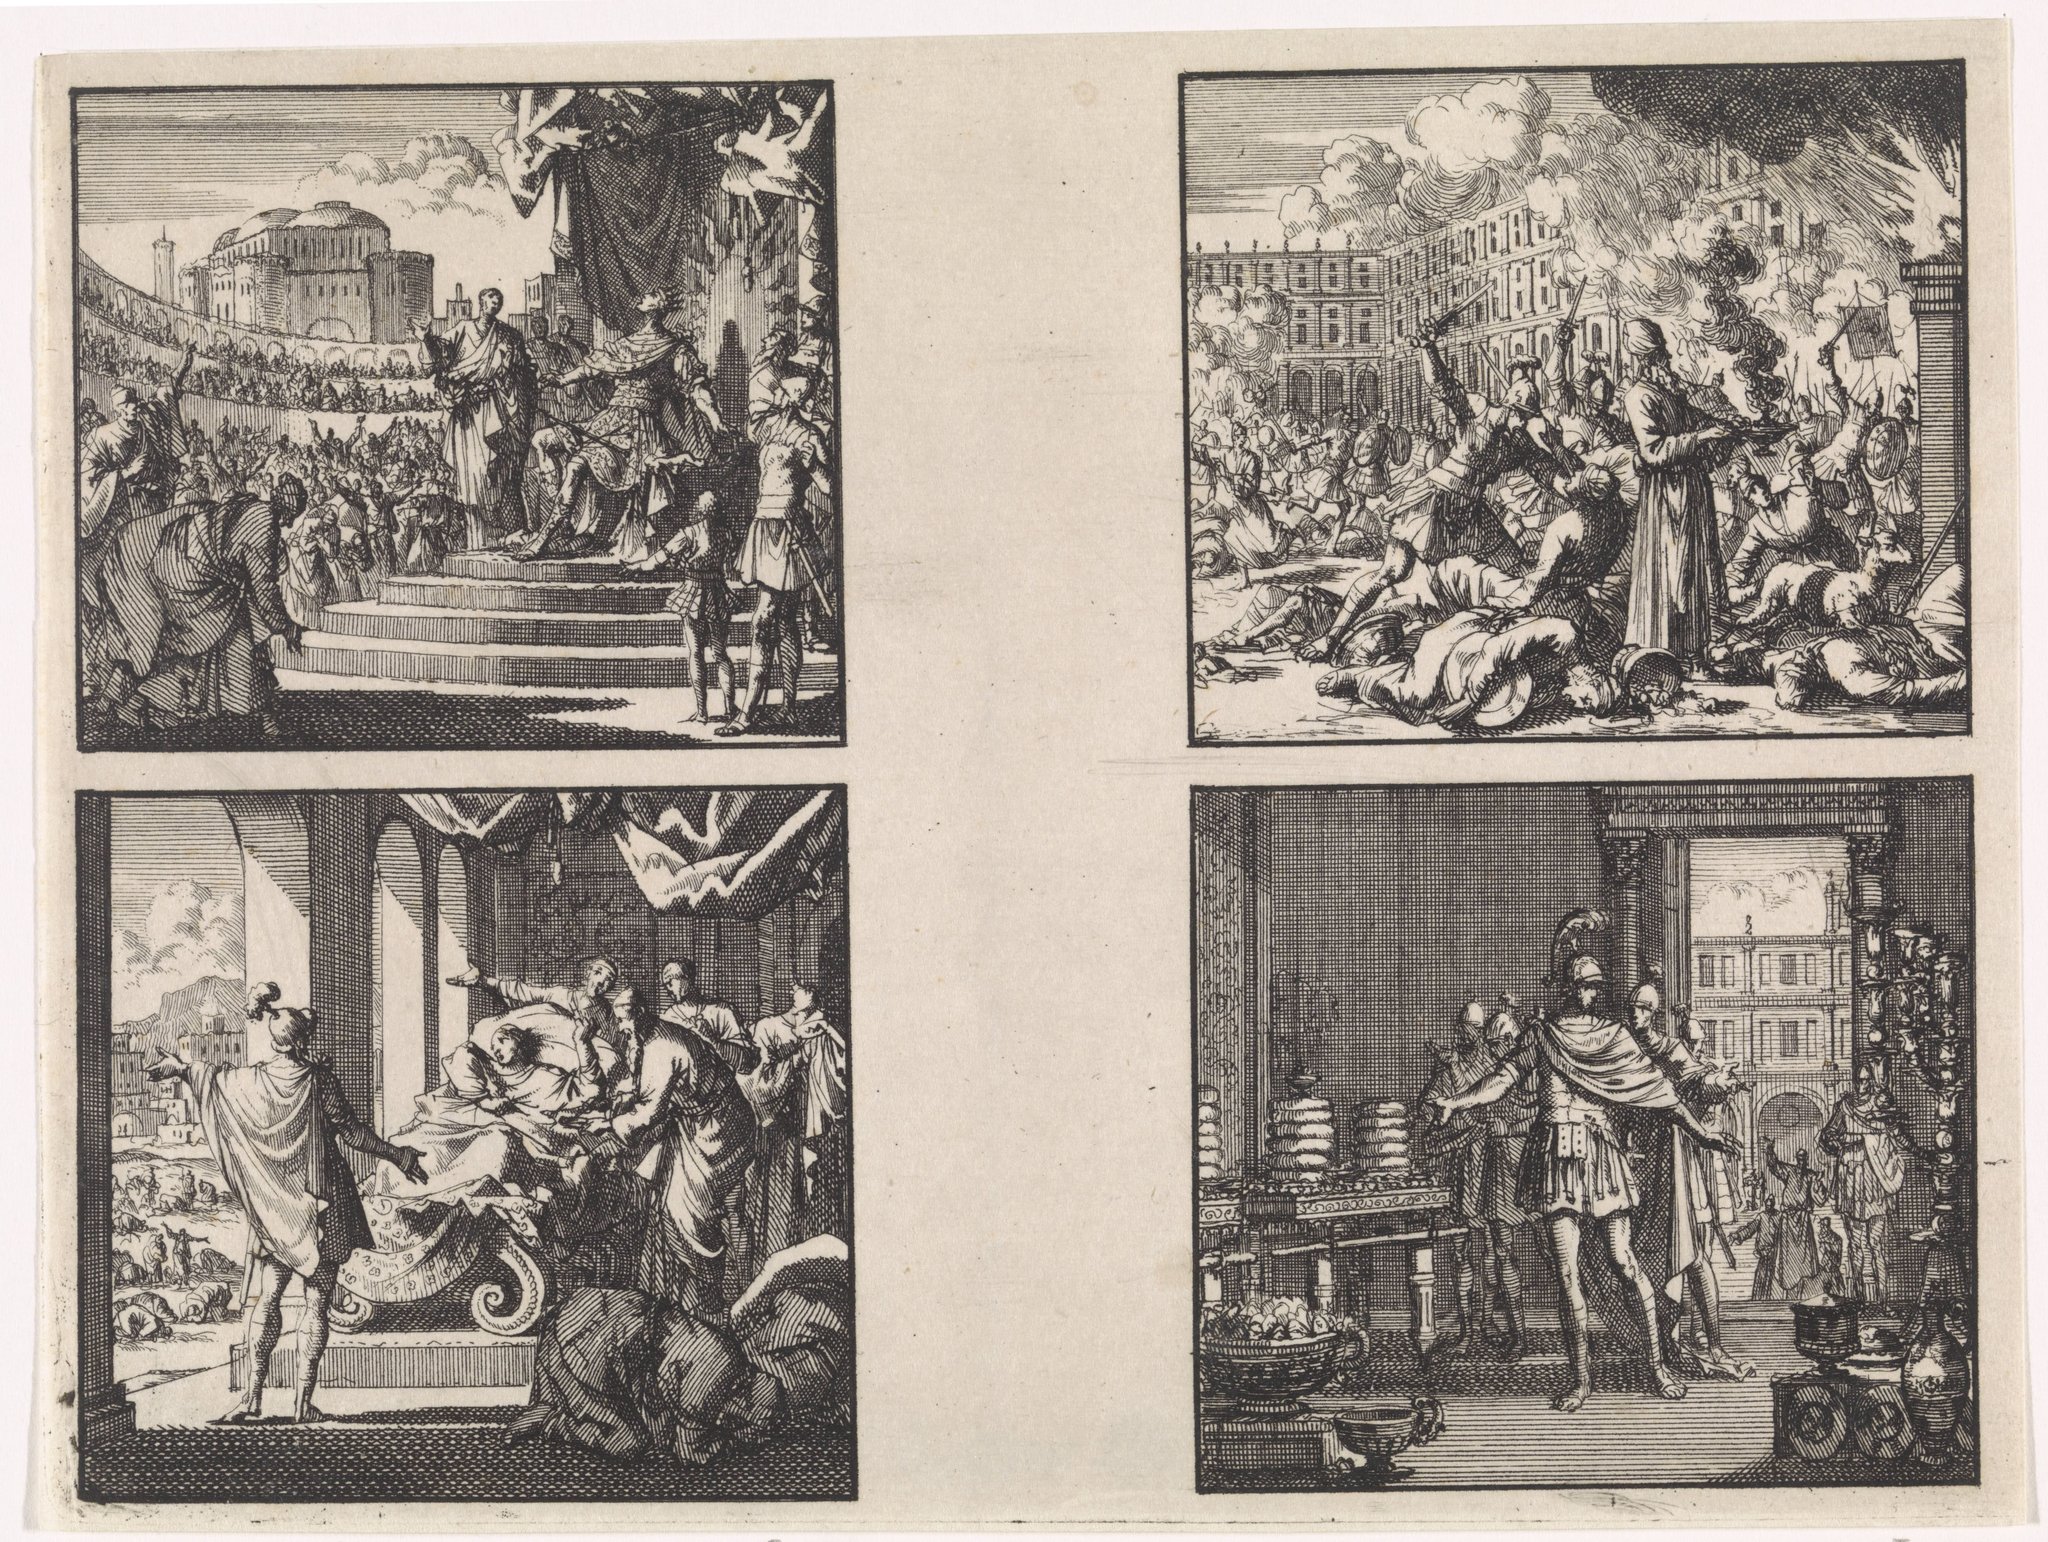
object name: print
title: Koning Agrippa ziet een uil boven zijn troon / Koning Agrippa sterft omgeven door hovelingen / Overrompeling van de tempel door de soldaten van Pompeius / Pompeius neemt de tempel te Jeruzalem in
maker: jan luyken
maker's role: draughtsman, print maker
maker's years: 1649-1712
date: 1698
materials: paper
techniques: etching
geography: amsterdam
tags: (story of) gnaeus pompeius magnus, pompey the great, capture of city (after the siege), owls, king herod agrippa speaks to the people; he is smitten by an angel and dies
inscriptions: collector's mark: Lugt 2228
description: Proefdruk van illustraties uit: Josephus, Flavius. XX. boeken van de oude geschiedenissen der joden, 4 delen. Amsterdam: Barent Visscher, Willem de Coup, Willem van Lamsveld, Andries van Damme, 1698, dl. II en III.